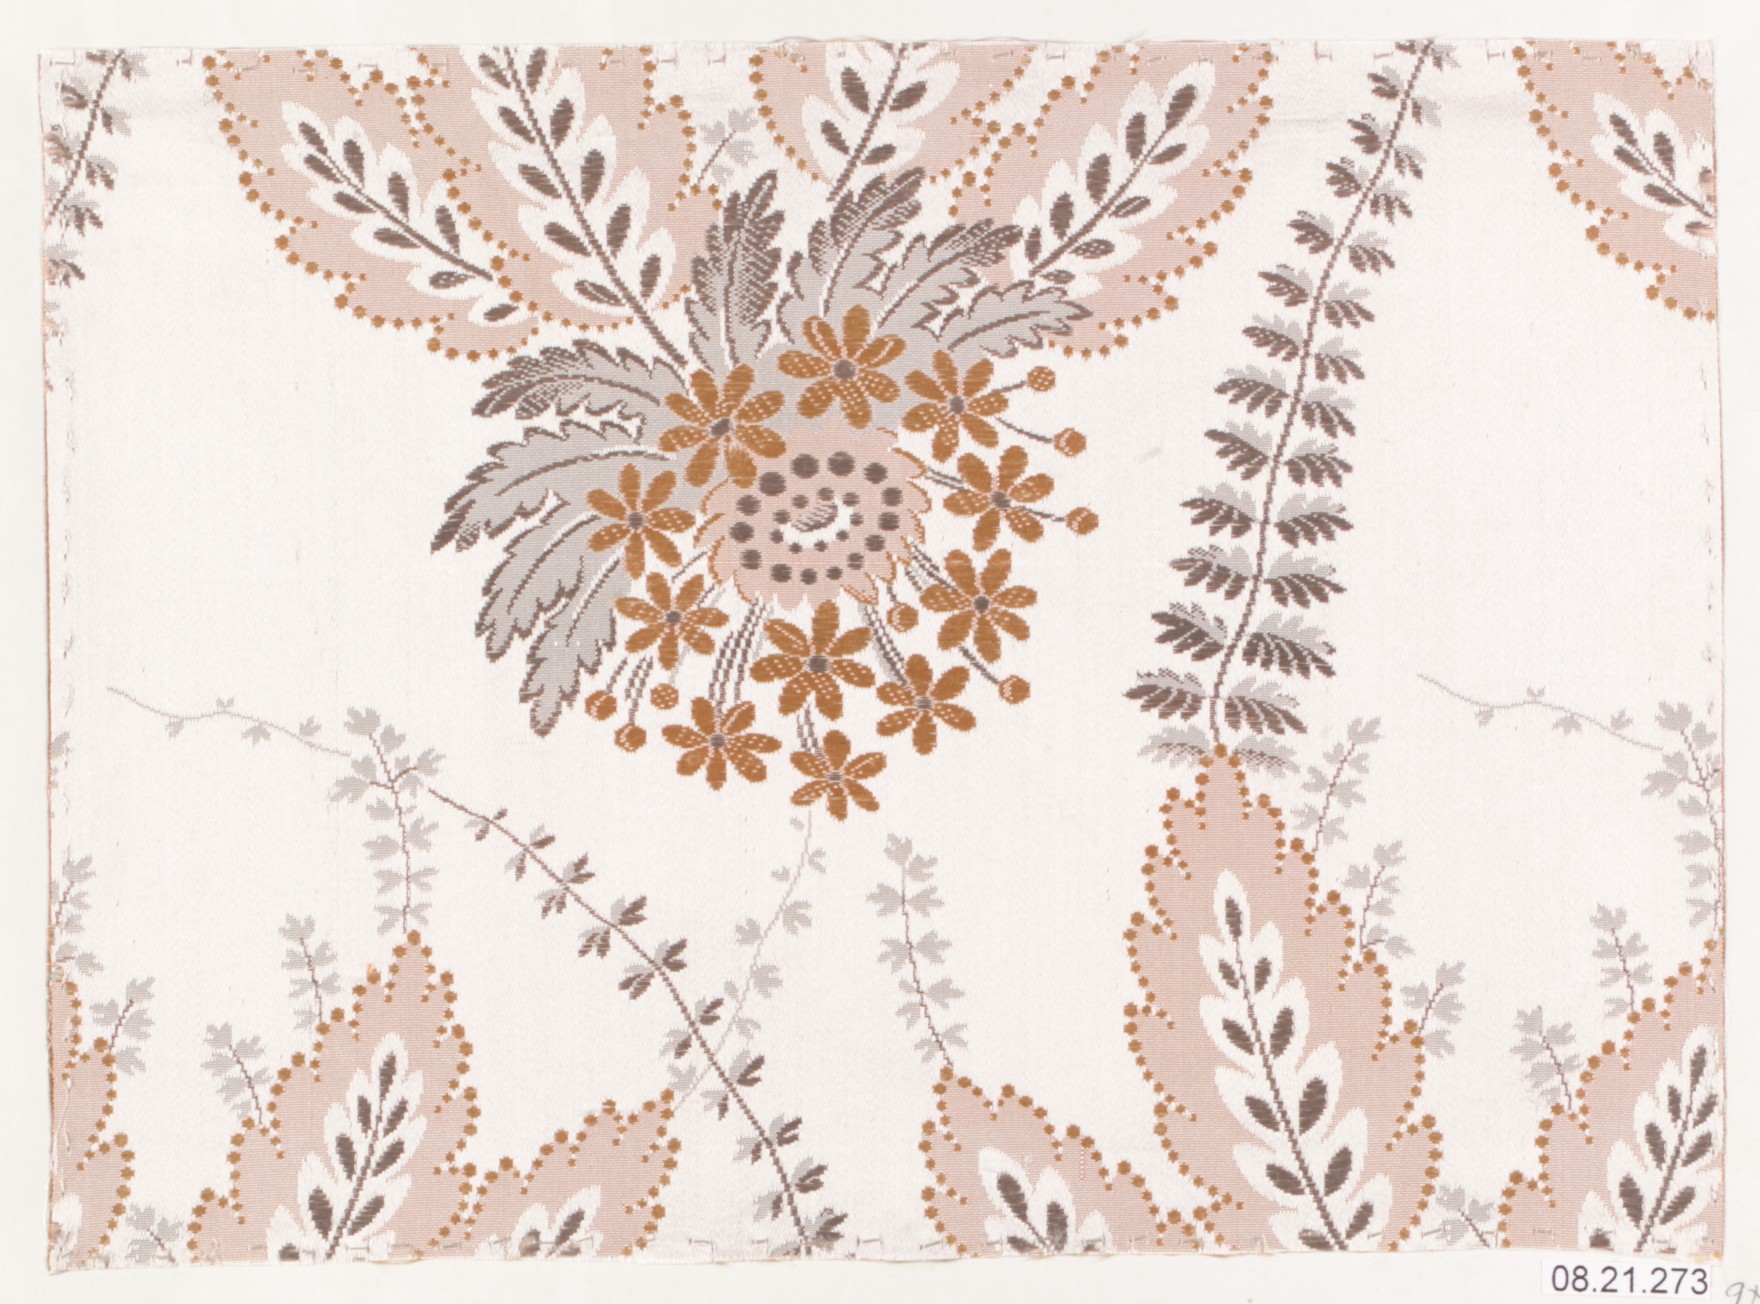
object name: textile sample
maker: Anonymous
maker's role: designer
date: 1900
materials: silk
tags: flowers,leaves